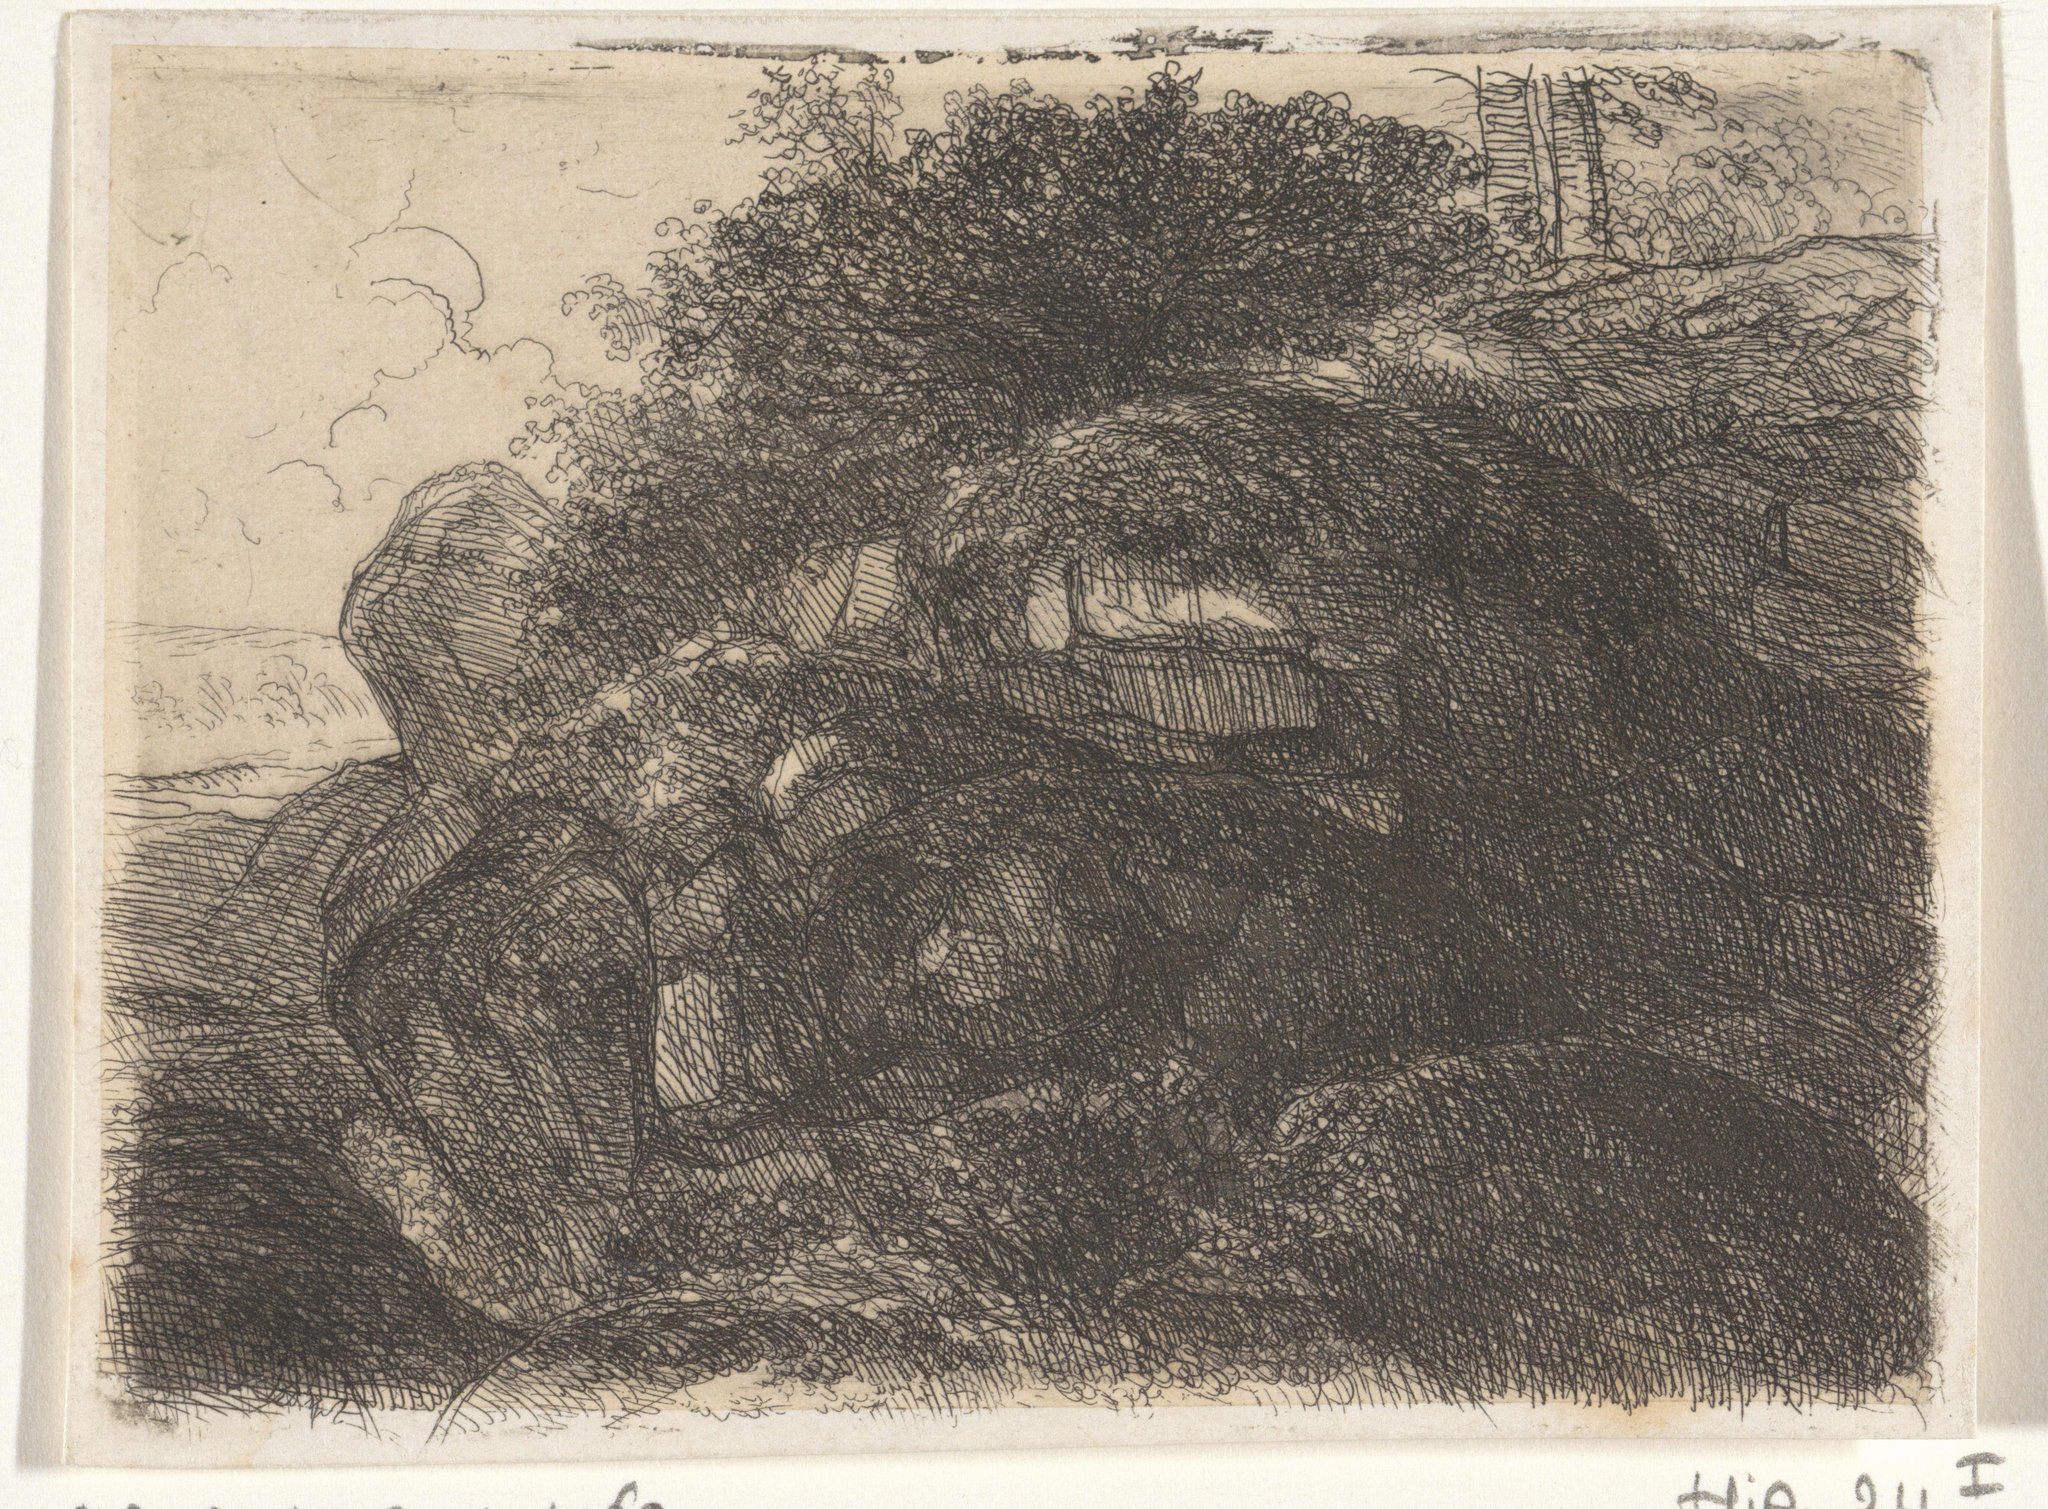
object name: print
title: Rotspartij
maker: alexander schaepkens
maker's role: draughtsman, print maker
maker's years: 1815-1899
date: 1830-1899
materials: paper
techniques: etching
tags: rock-formations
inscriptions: collector's mark: Lugt 2228